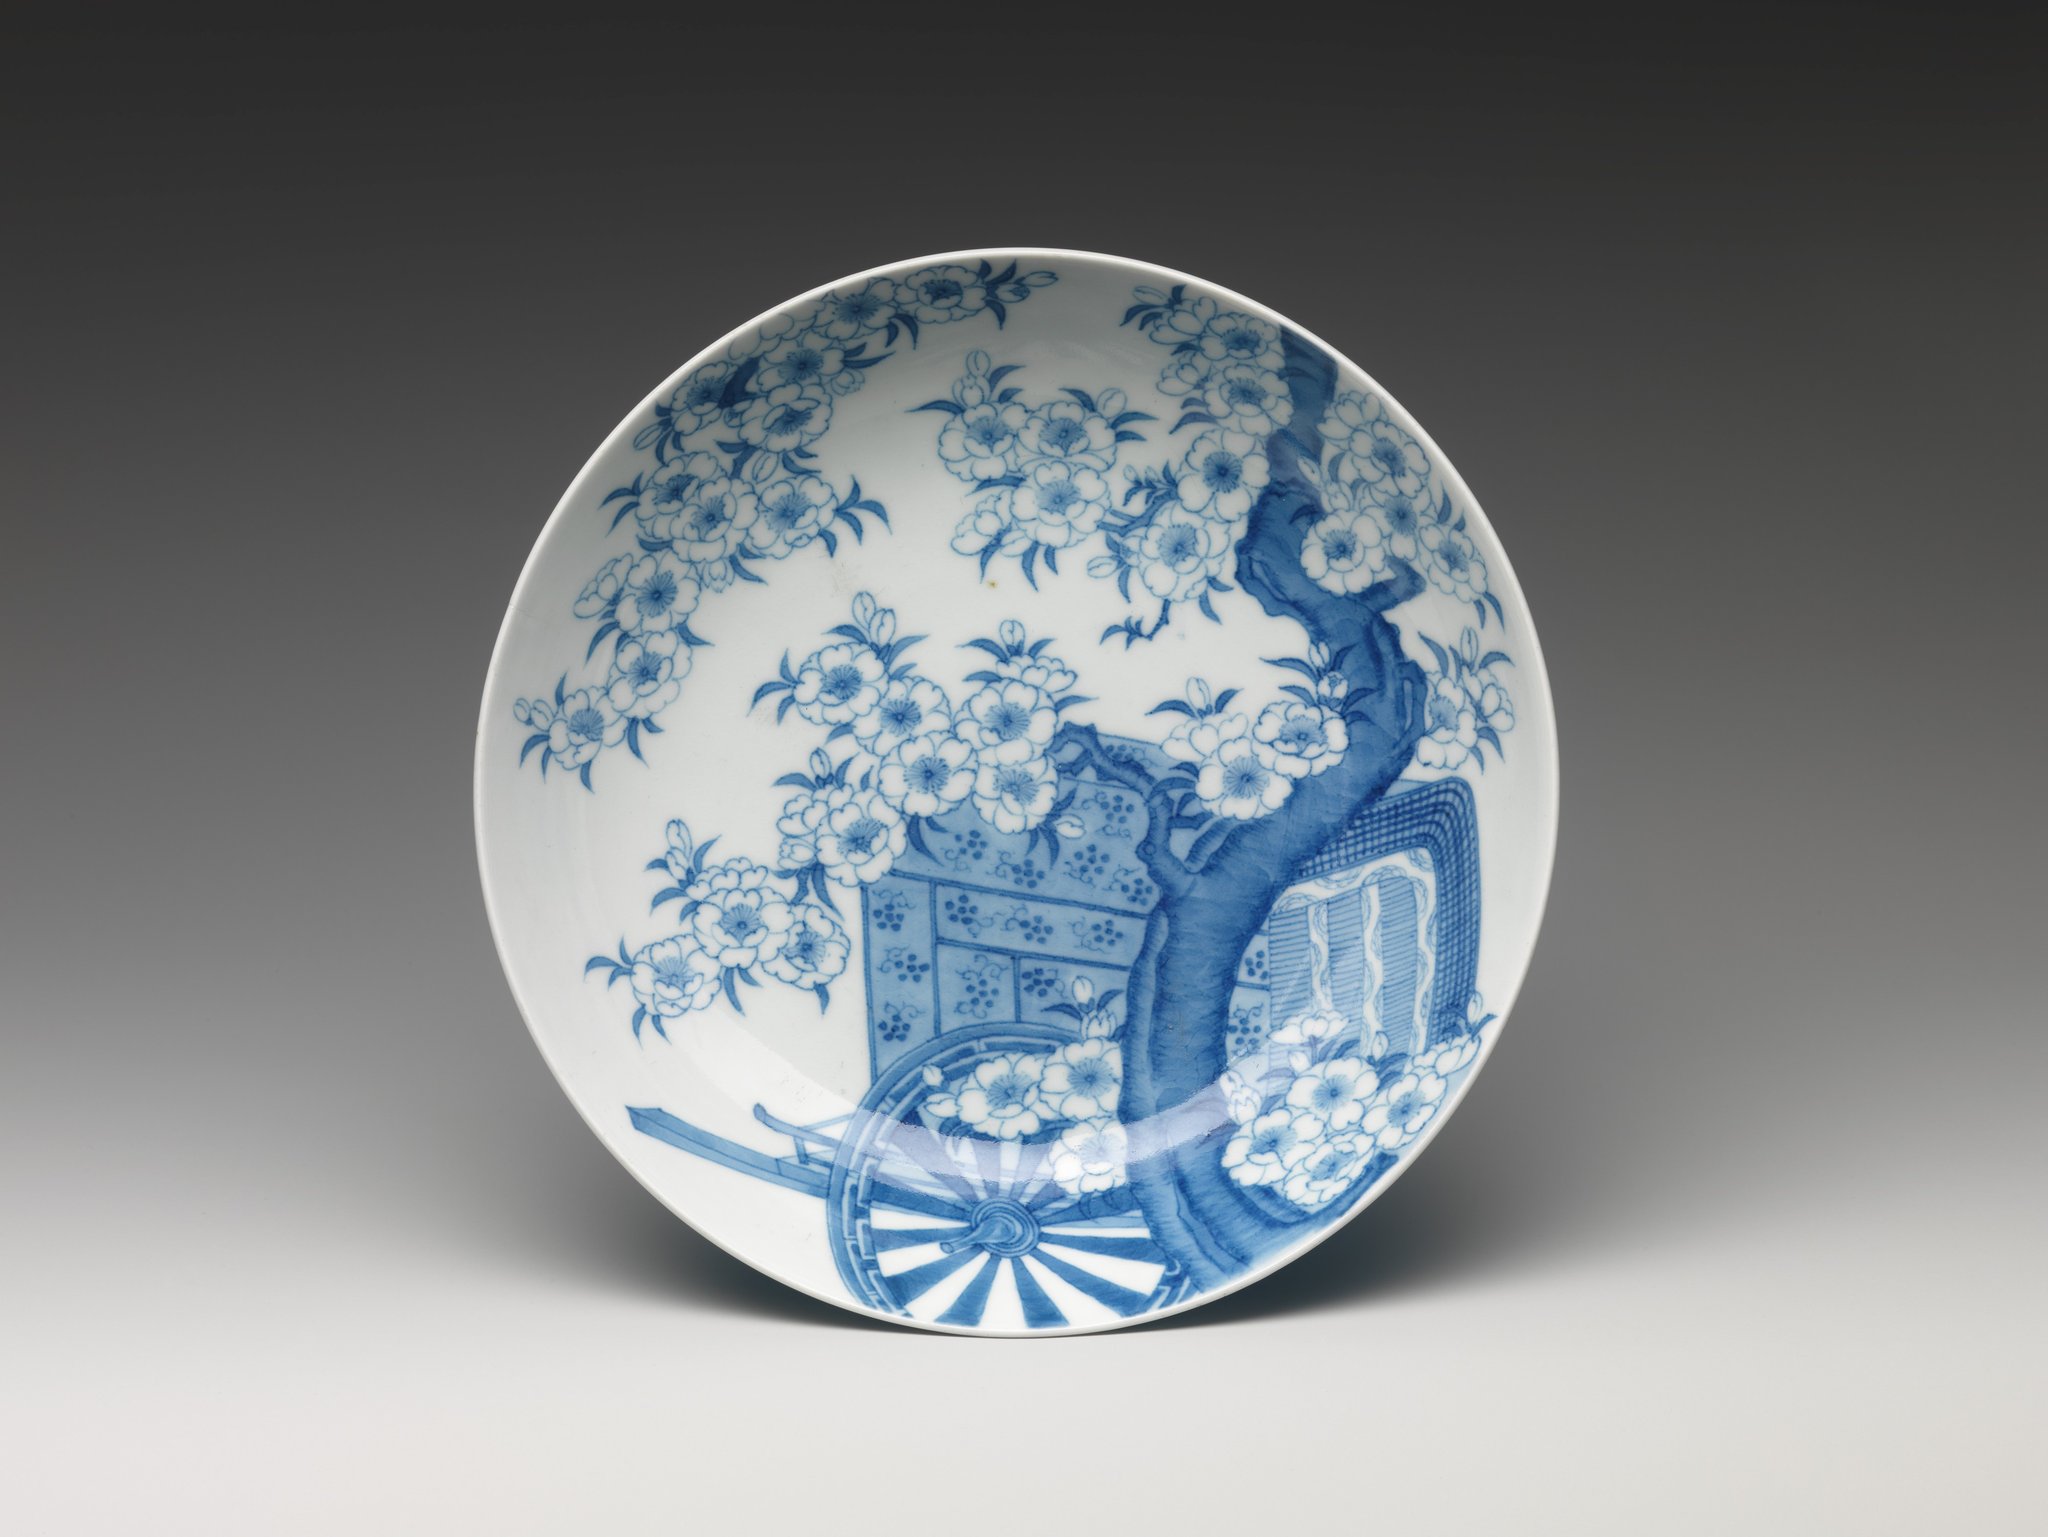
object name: plate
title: Dish with Court Carriage beneath a Cherry Tree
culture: japanese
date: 1770-1800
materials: porcelain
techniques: underglaze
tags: flowers,trees,carriages